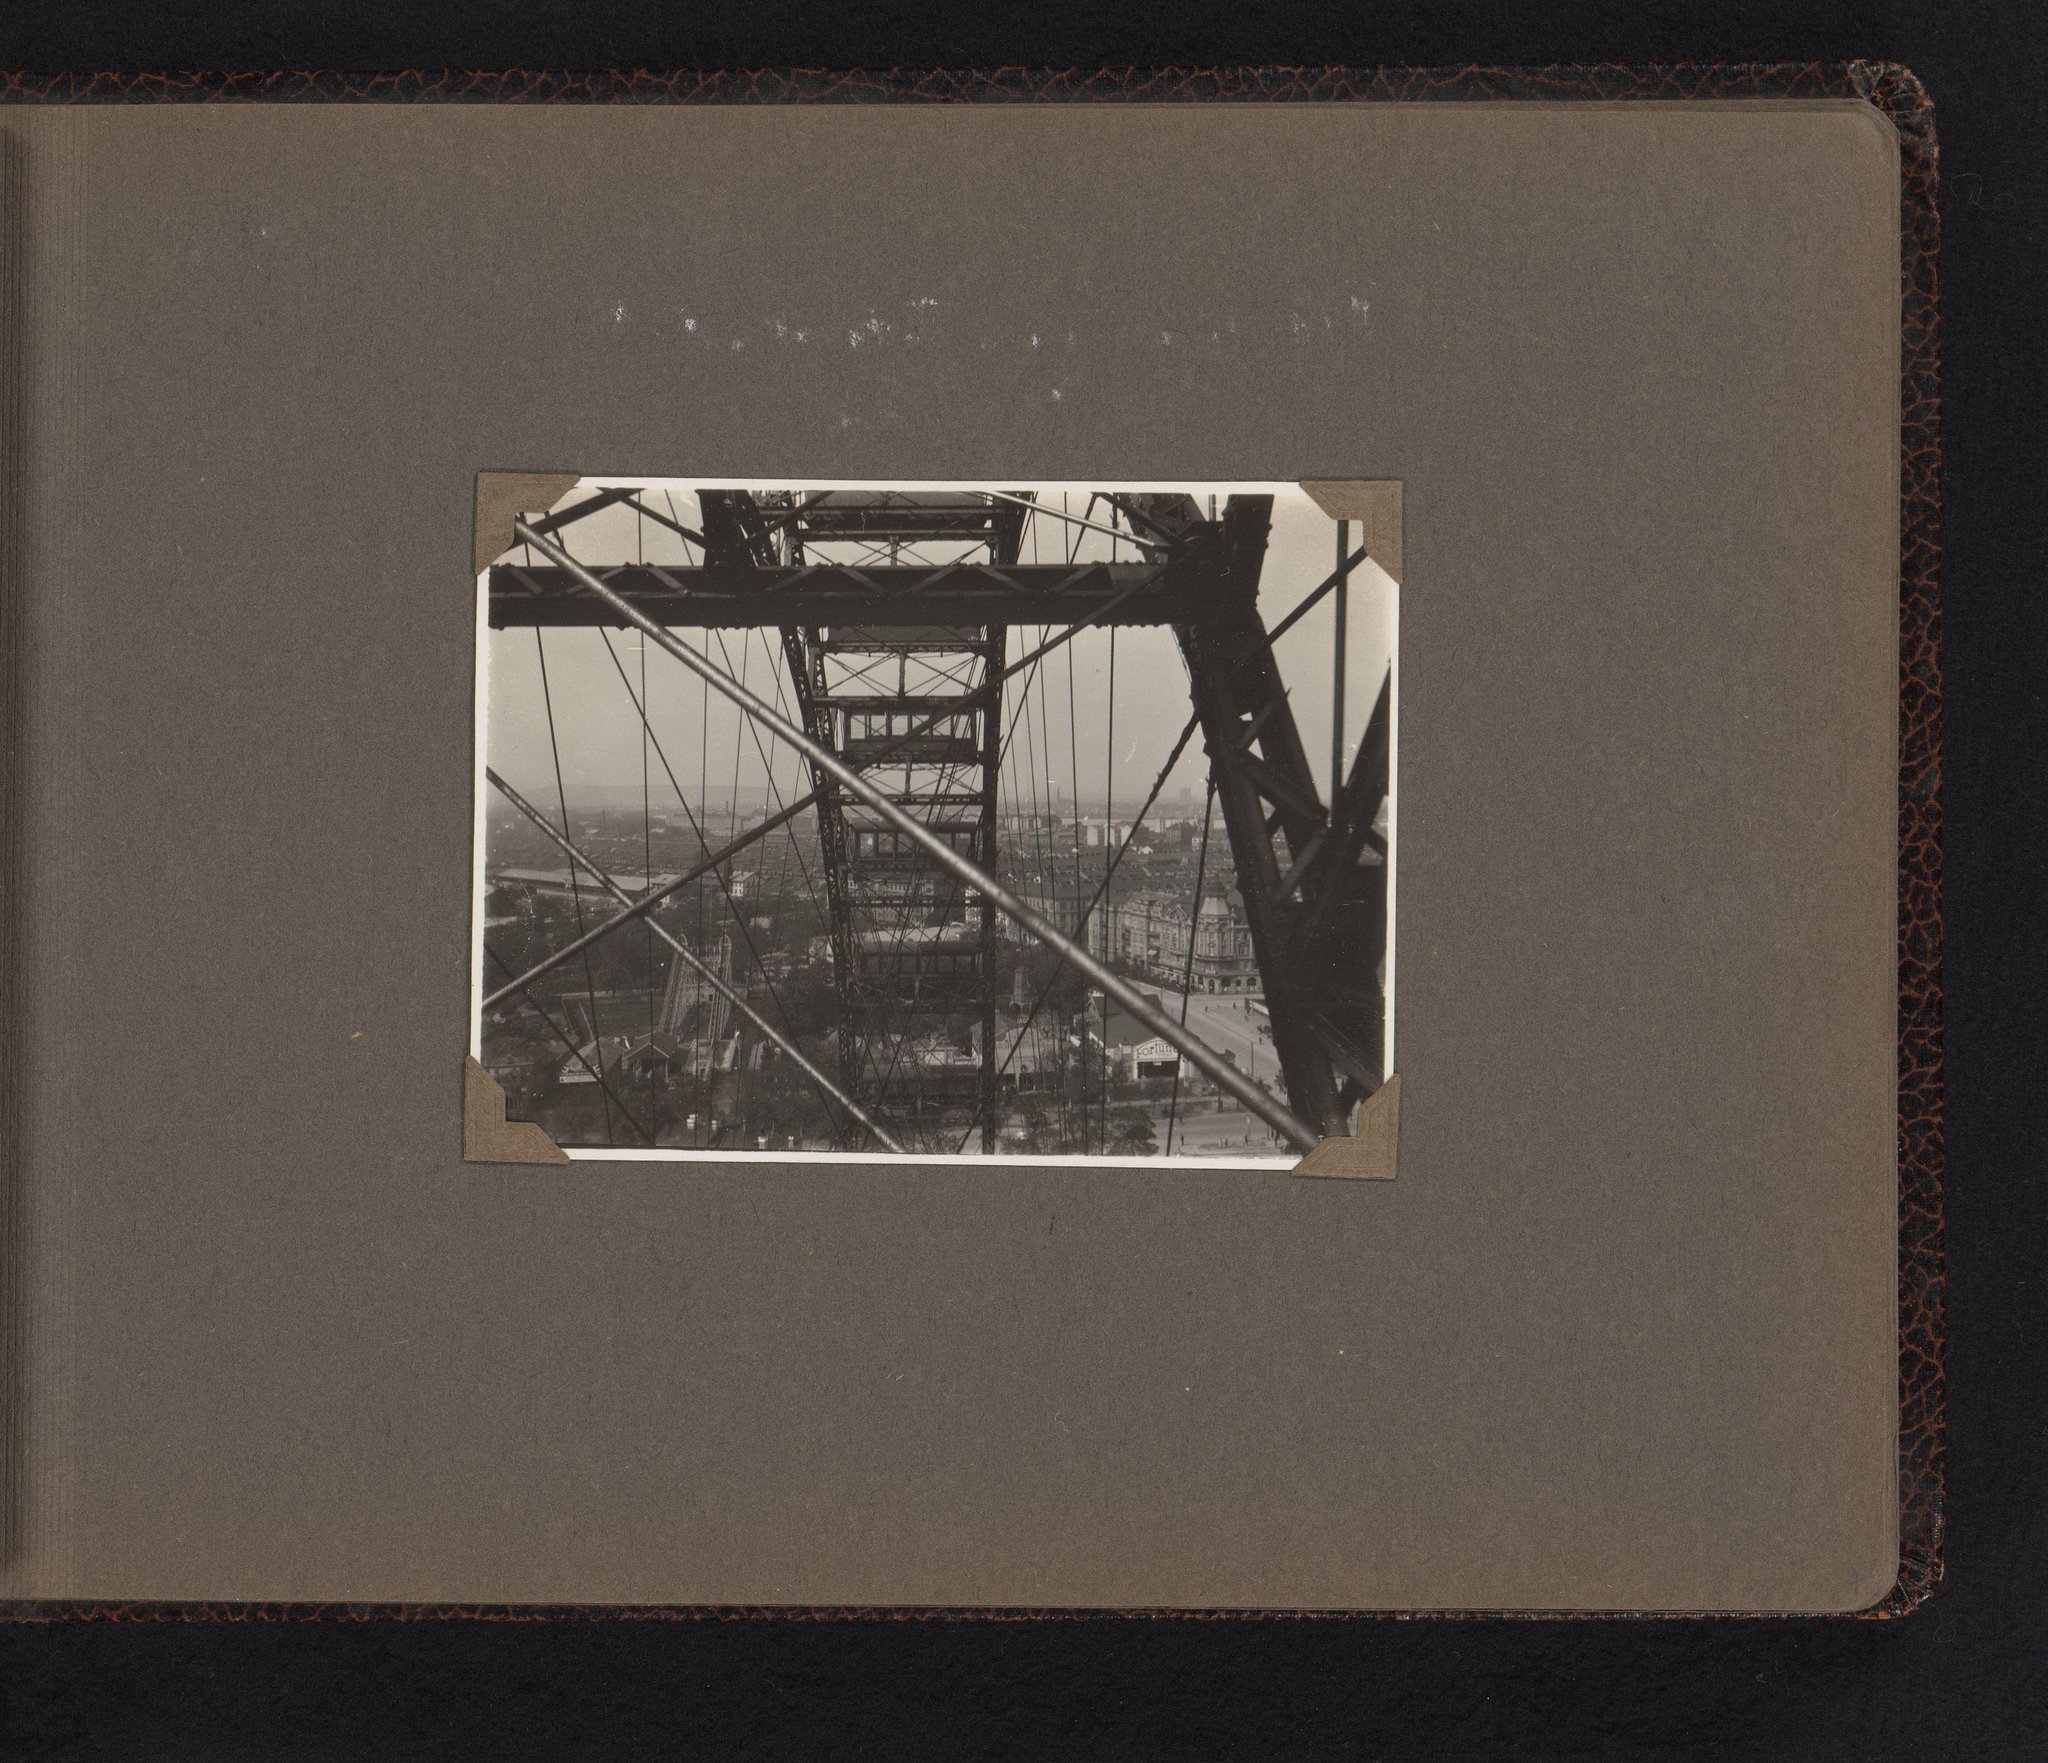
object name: photograph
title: Gezicht op Wenen vanuit het reuzenrad in het Prater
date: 1930-1931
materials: cardboard, paper, photographic support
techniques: gelatin silver print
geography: vienna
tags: city-view in general; 'veduta', giant wheel, ferris wheel, vienna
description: Deze pagina maakt deel uit van een album.